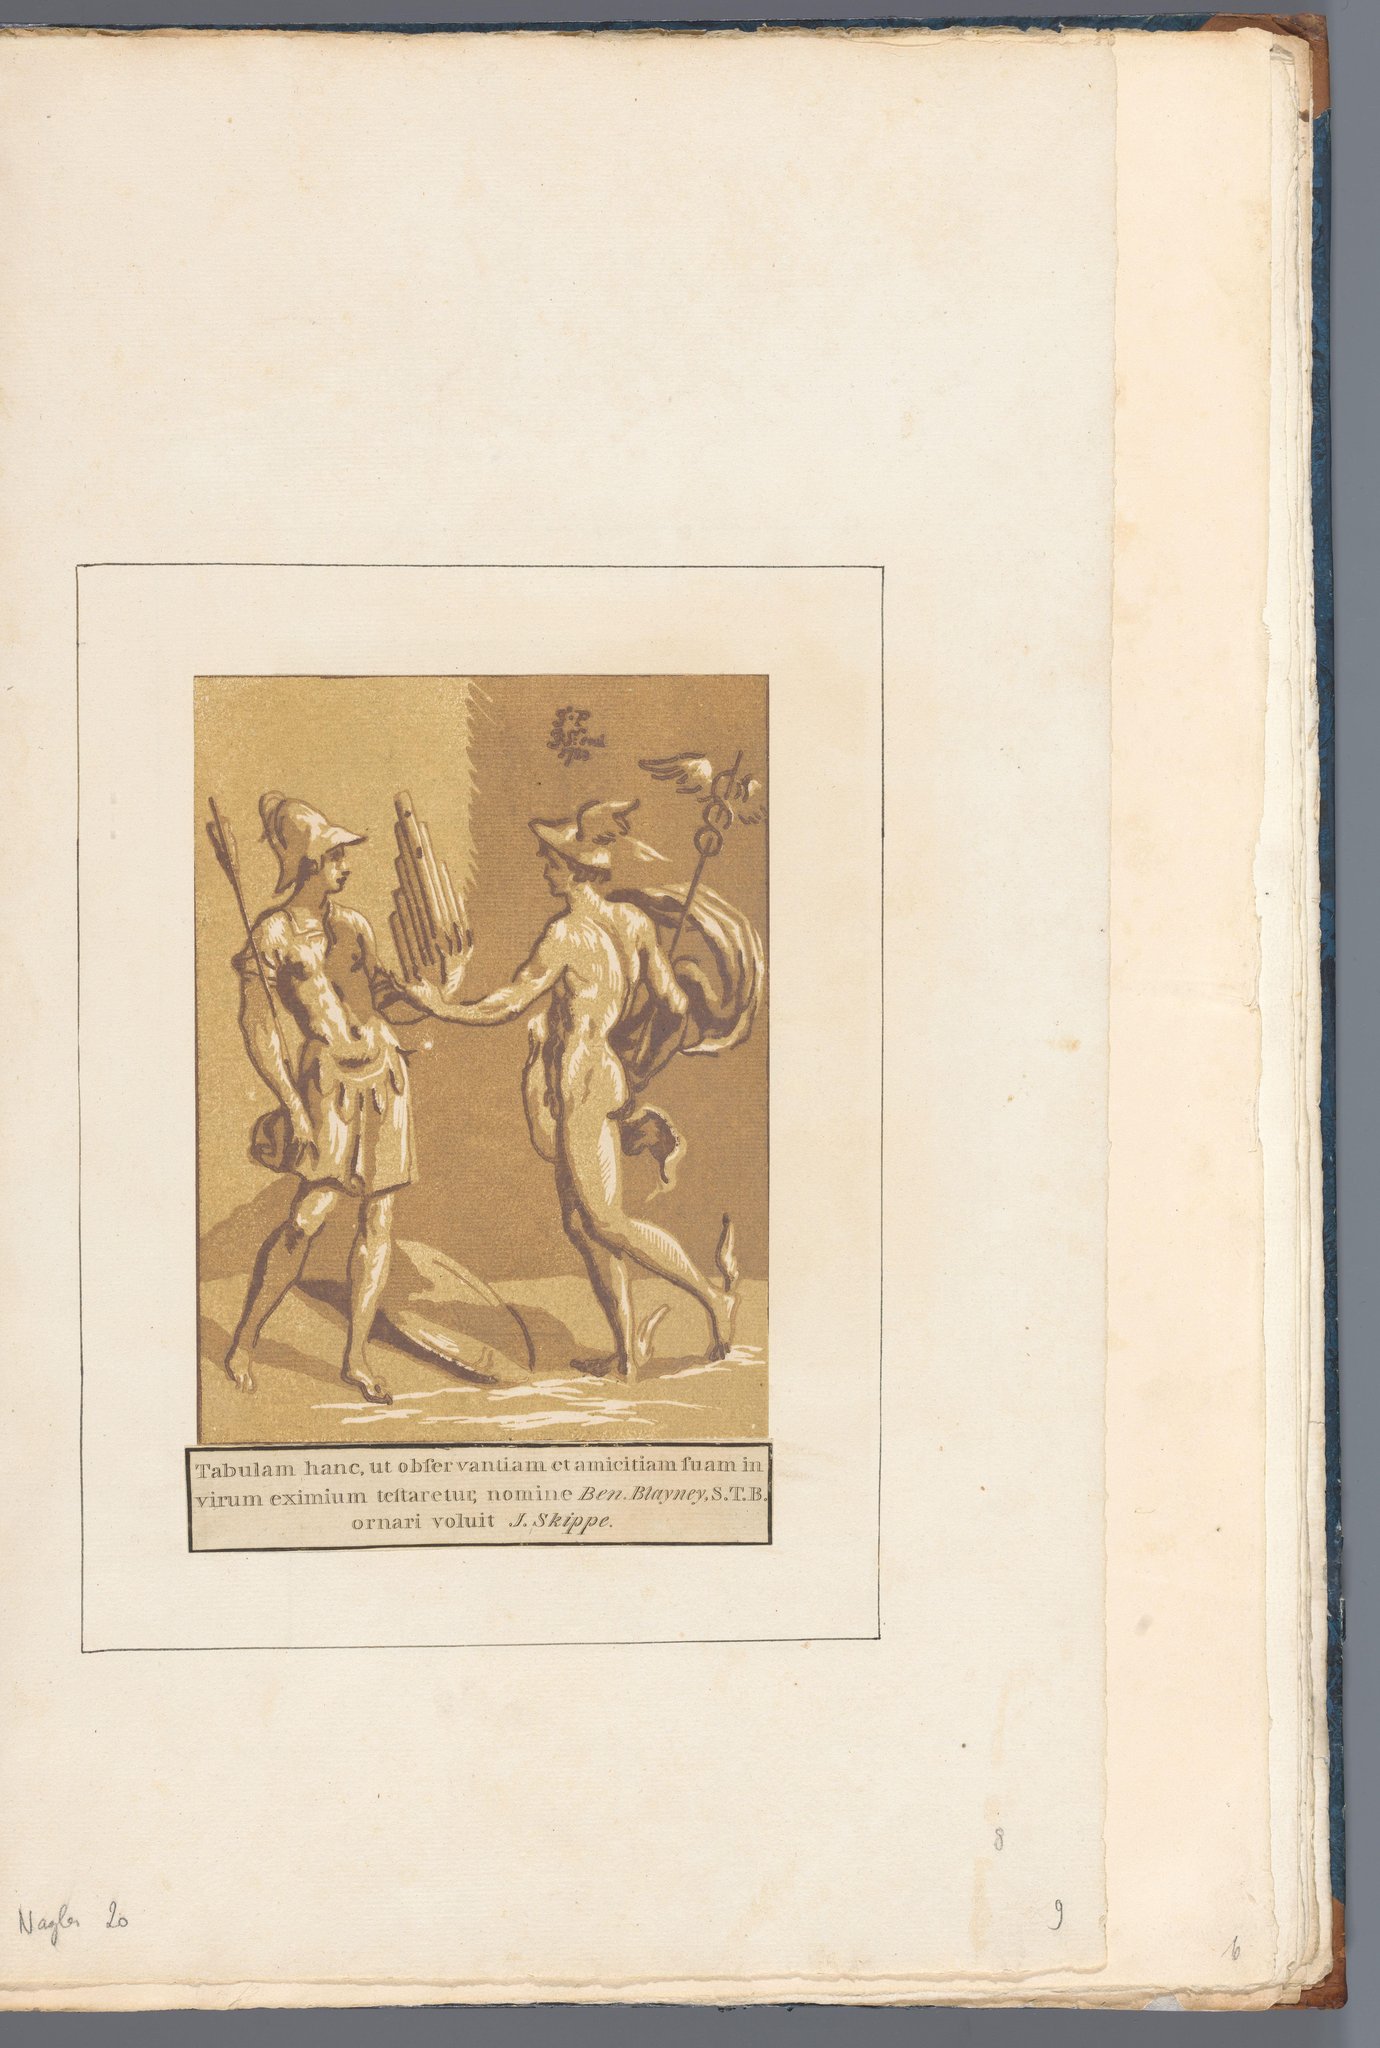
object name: print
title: Amicis suis necnon unicuique (...)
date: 1783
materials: ink, paper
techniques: woodcut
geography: england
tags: (story of) minerva (pallas, athena), (story of) mercury (hermes), panpipes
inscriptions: date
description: Mercurius overhandigt een panfluit aan Minerva. Met etiket met drieregelige tekst in het Latijn met de naam: Ben. Blayney. Onderdeel van een album met 26 ingeplakte clair-obscur houtsneden naar Italiaanse kunstenaars uit de zestiende eeuw.